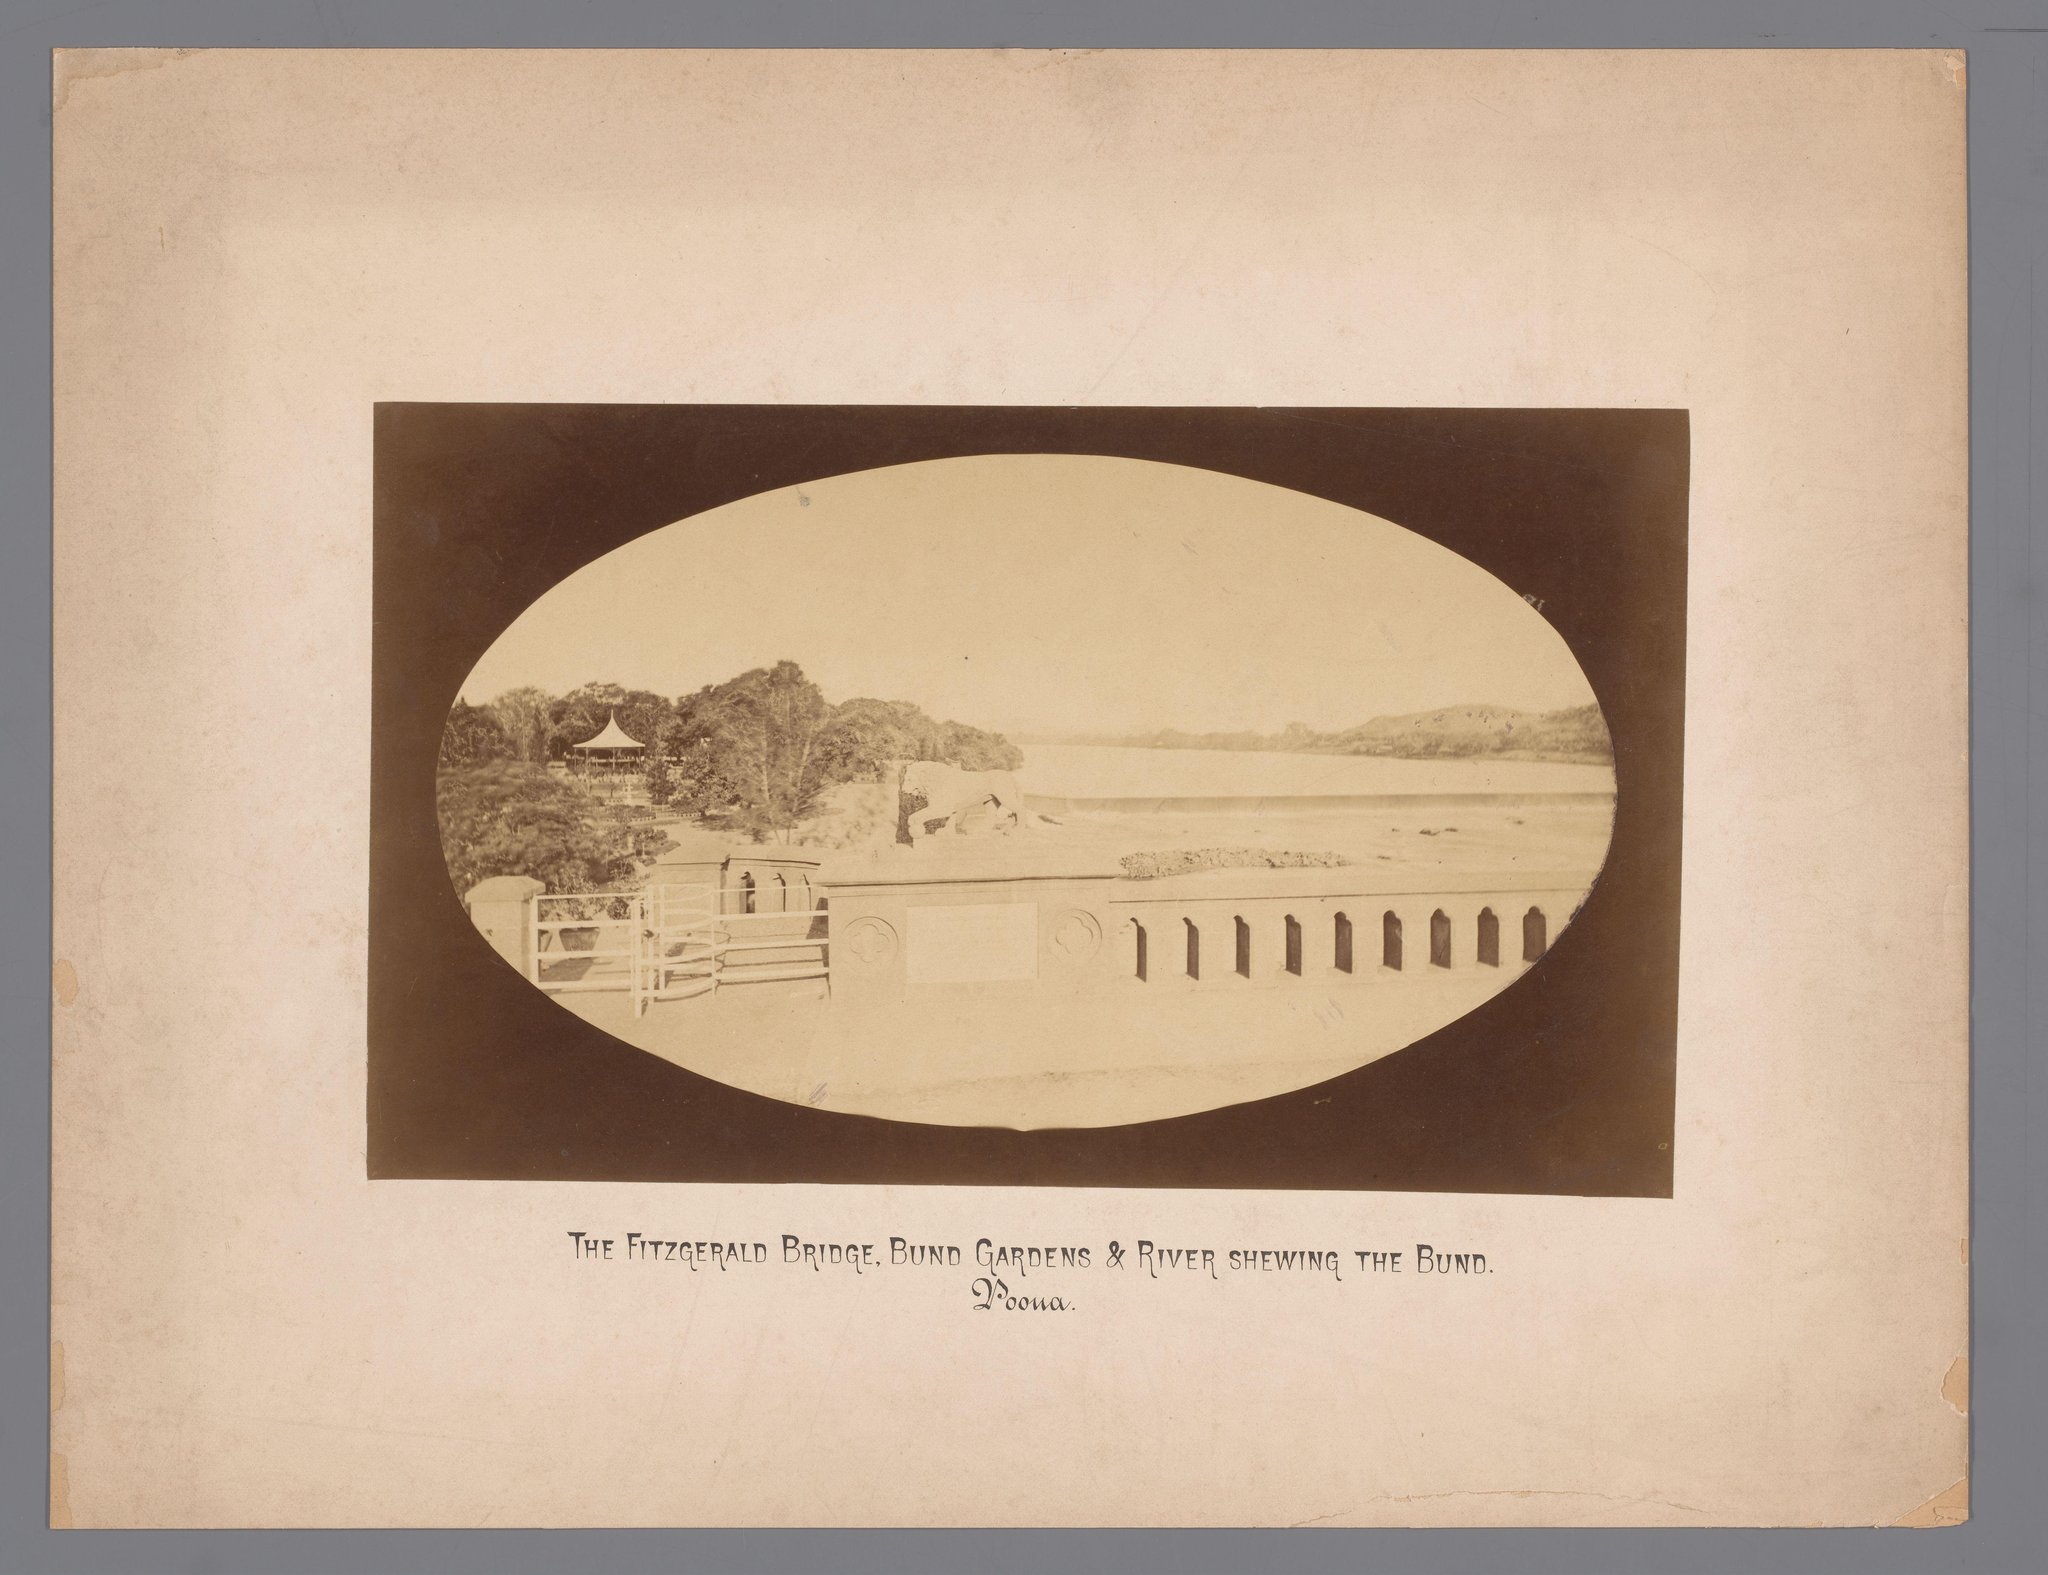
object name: photograph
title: Fitgerald Bridge, Bund Gardens and Mula Mutha river, Pune, Maharashtra, India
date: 1875-1900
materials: cardboard, photographic support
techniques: albumen print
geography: pune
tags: india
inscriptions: inscription: ‘The Fitzgerald Bridge + Bund Gardens + River shweing the Bund/ Poona’, inscription: ‘THE FITZGERALD BRIDGE, BUND GARDENS & RIVER SHEWING THE BUND./ Poona.’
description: Ovale foto van een brug met rivier en links een park. Poona, ook wel Pune en Puna is een Indiase stad niet ver van Mumbai.